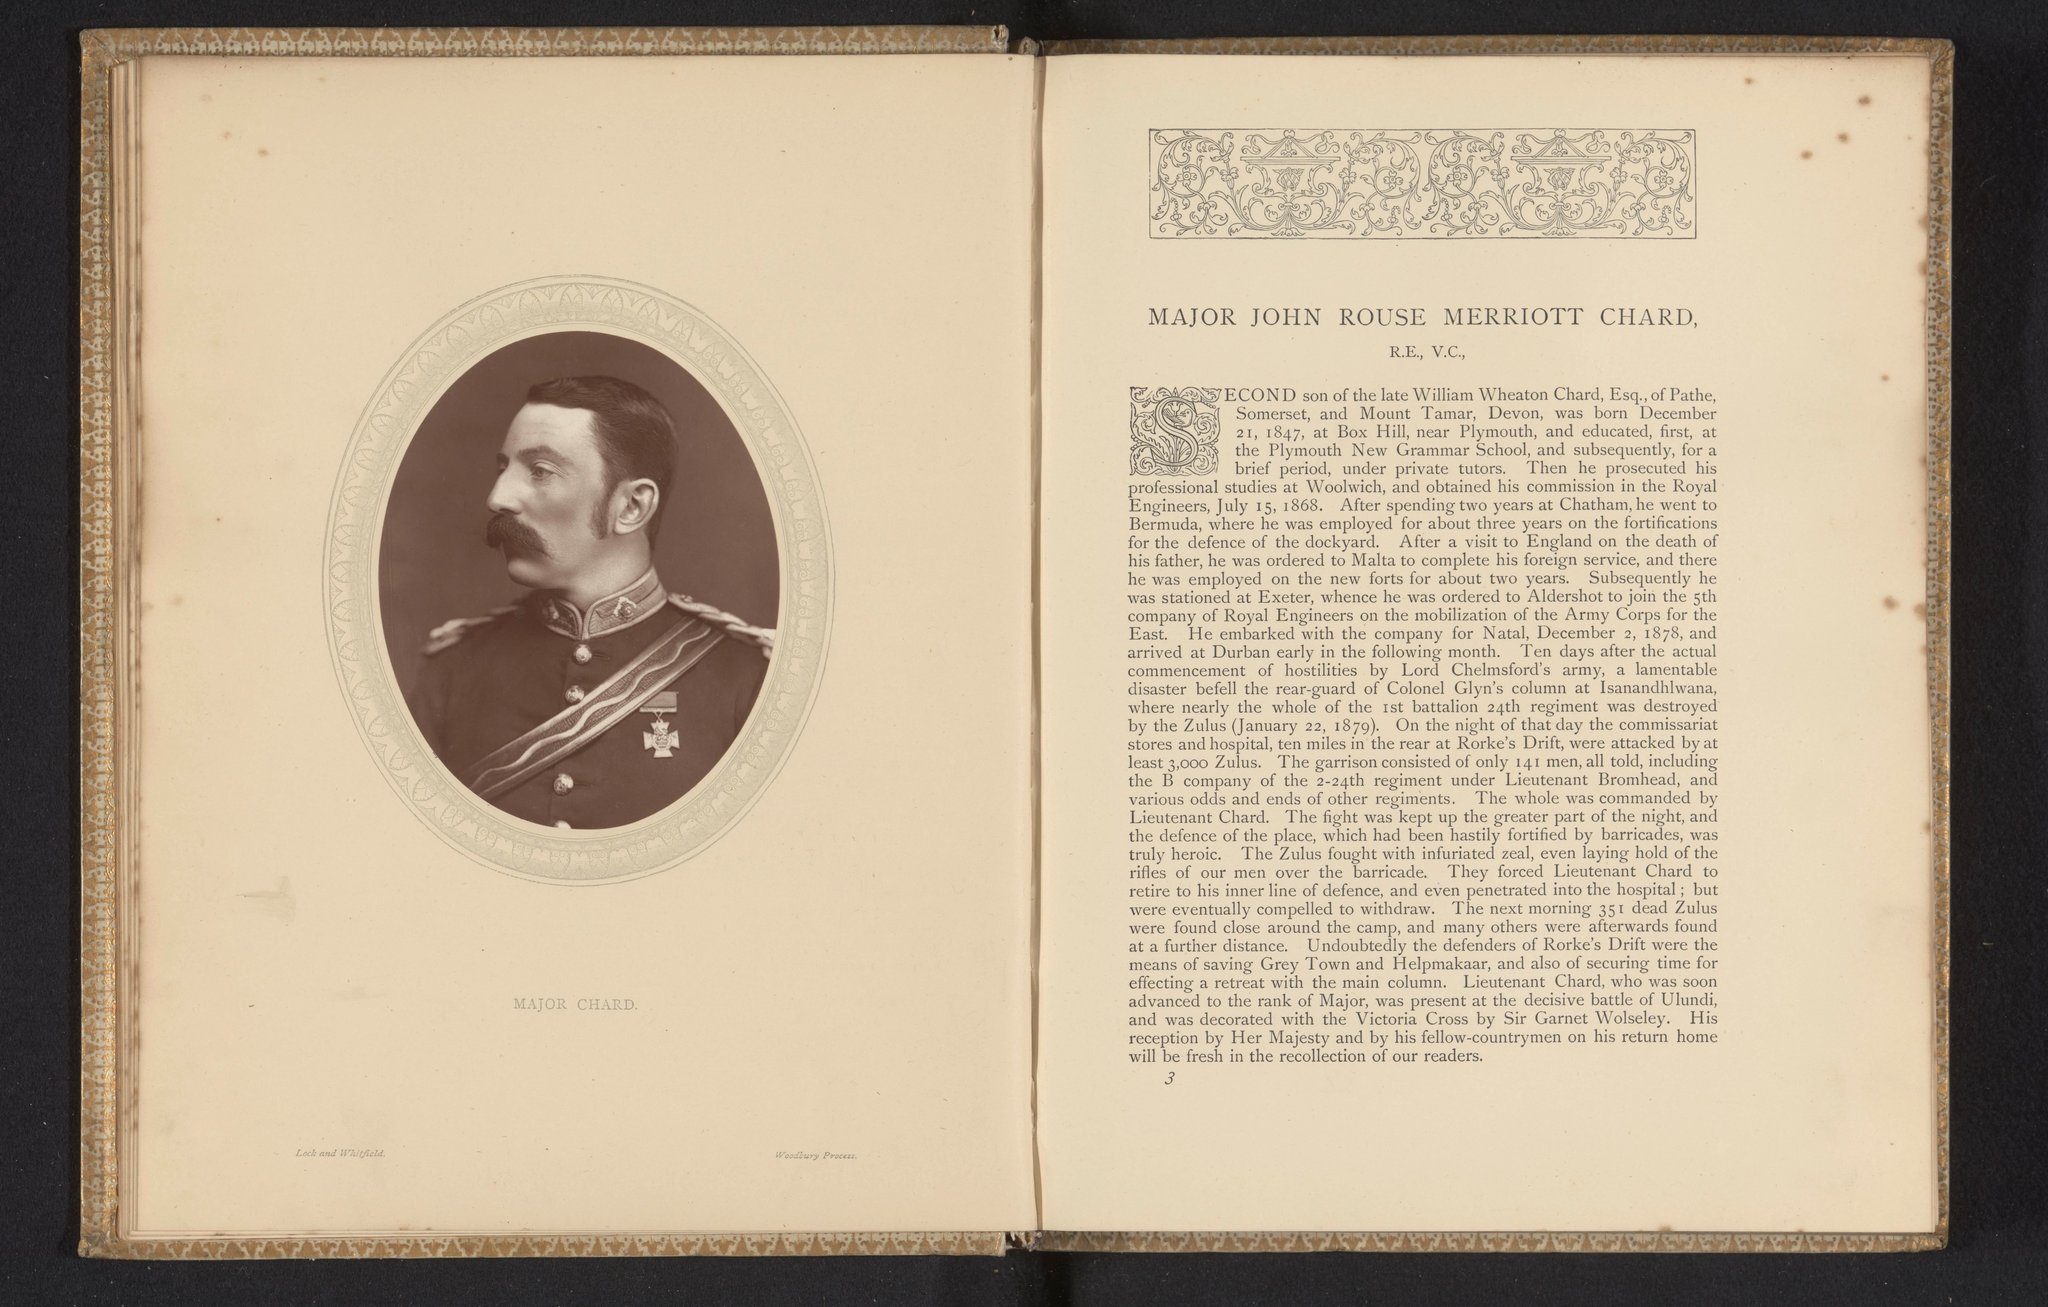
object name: page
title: Major Chard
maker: Anonymous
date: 1876-1881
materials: paper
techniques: woodburytype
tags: historical persons (portraits and scenes from the life) (+ (full) bust portrait), officer